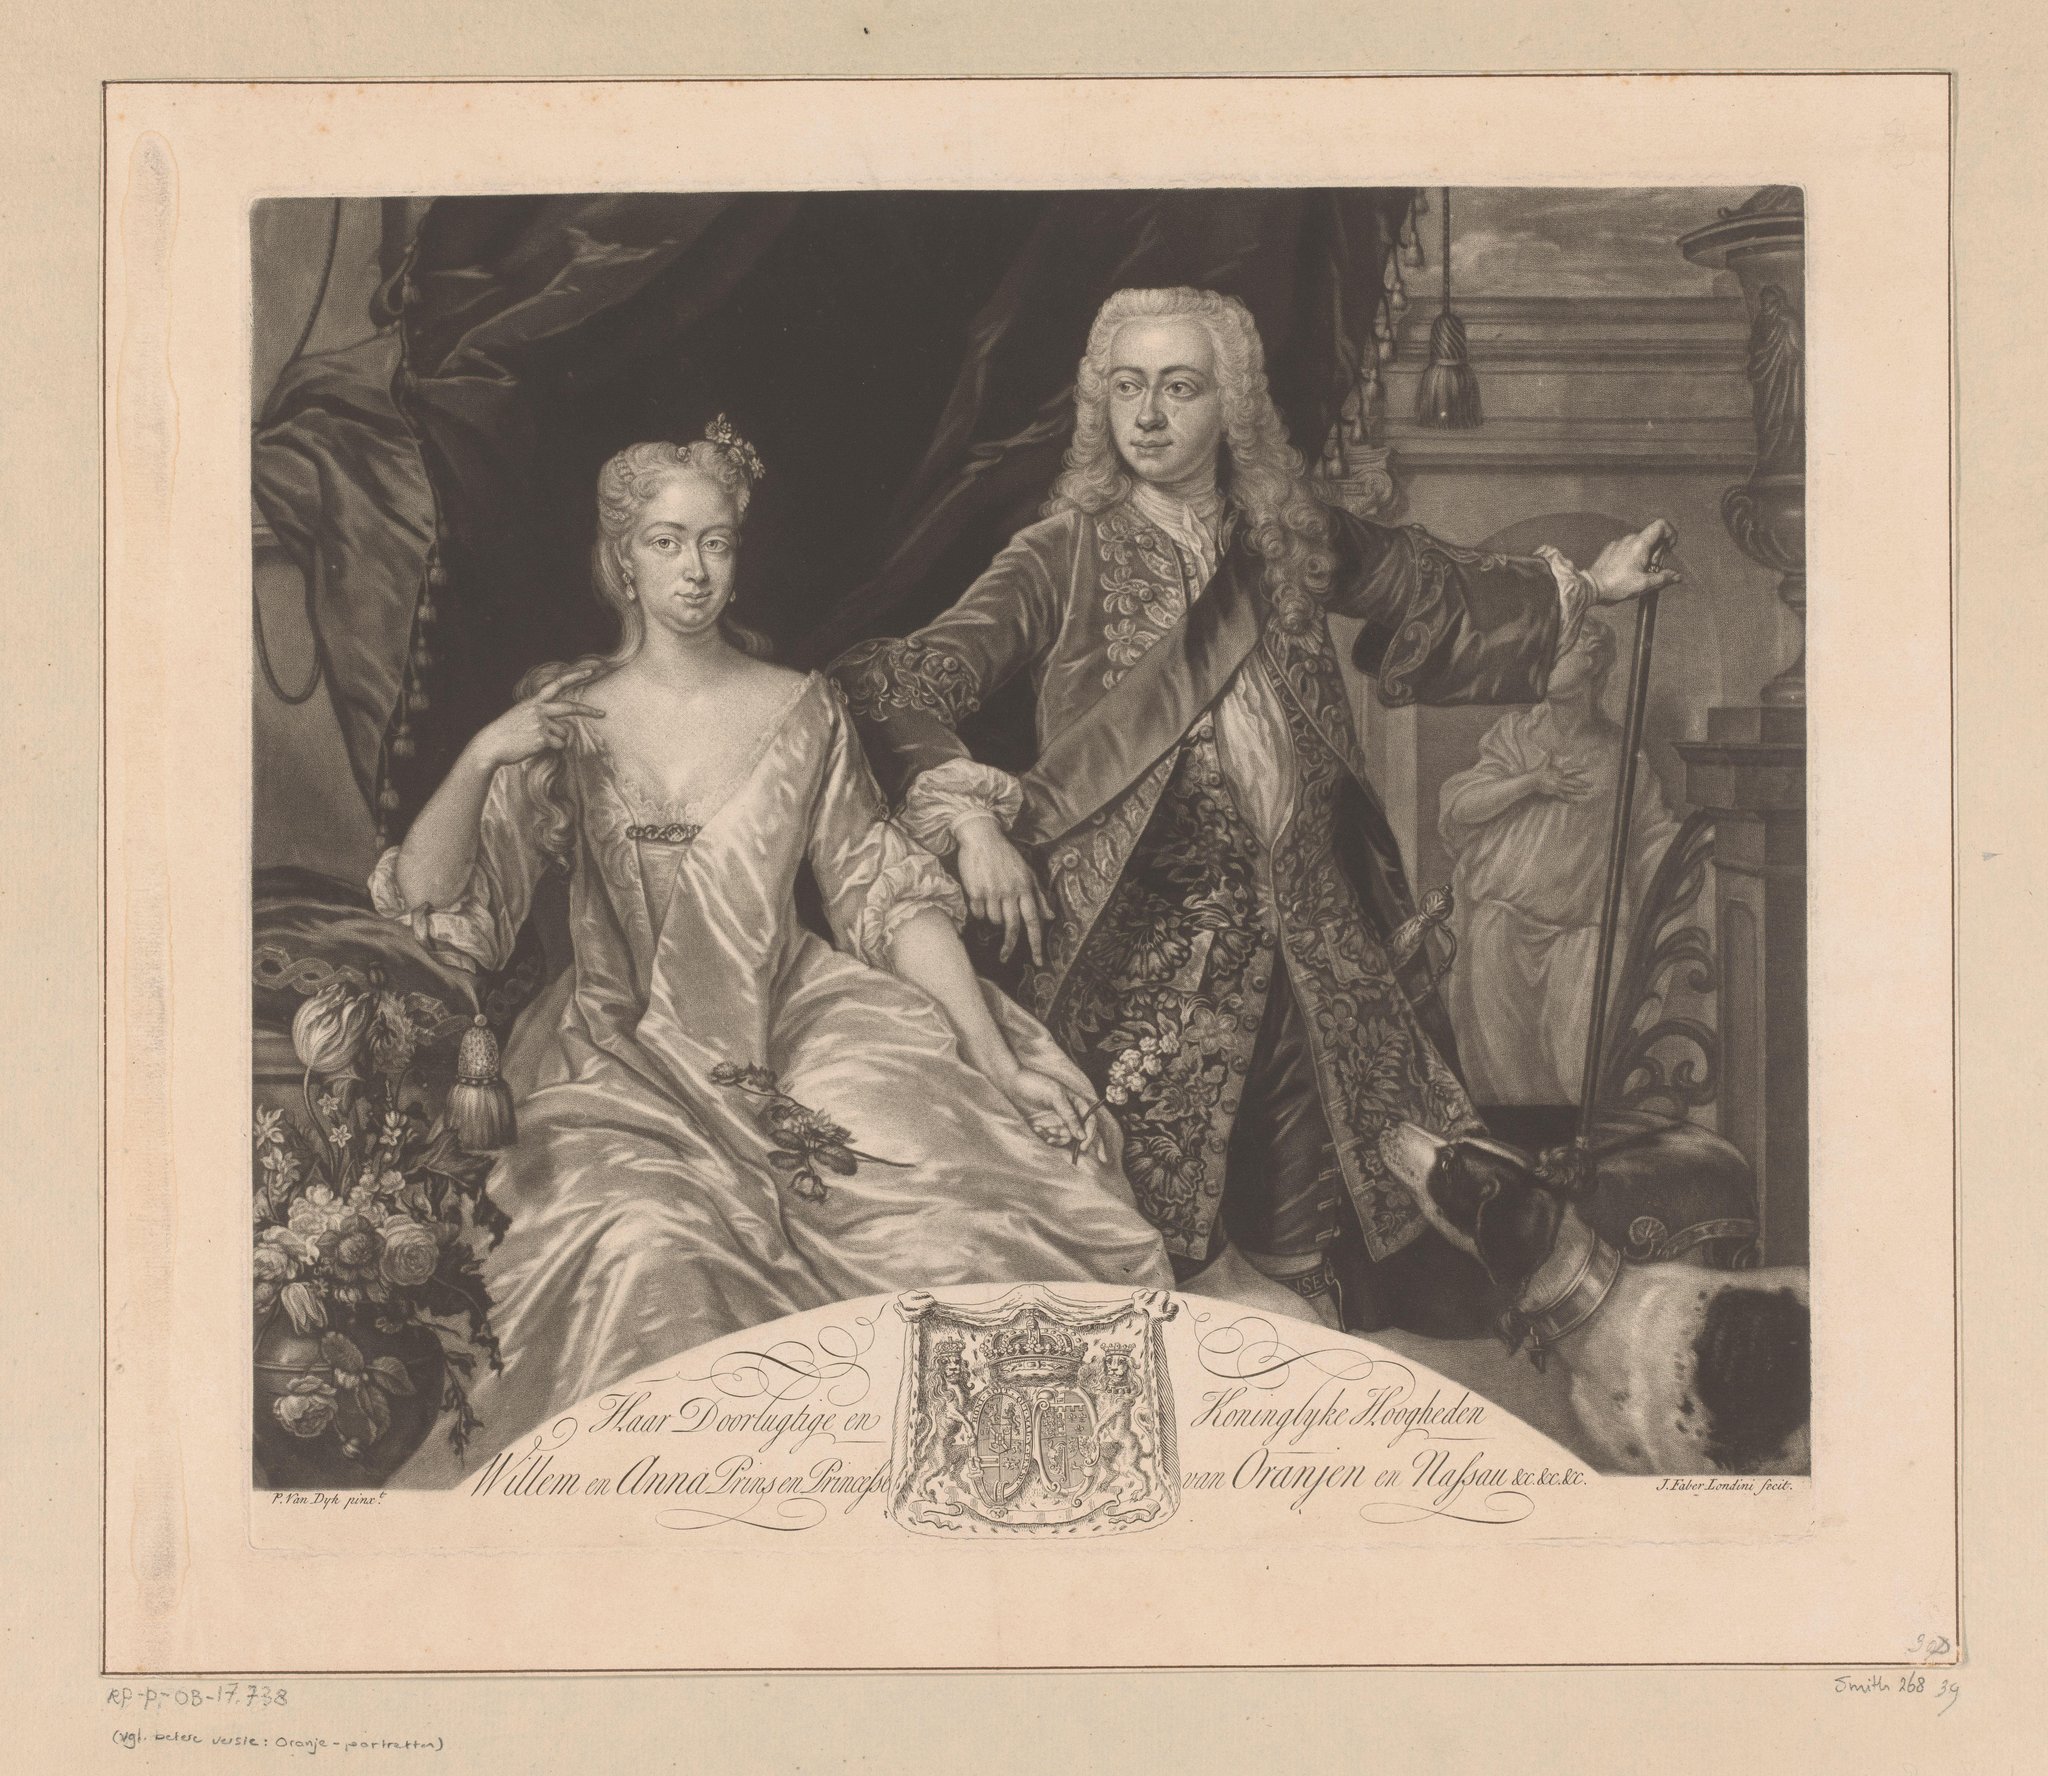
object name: print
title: Portret van Anna van Hannover en Willem IV, stadhouder en prins van Oranje-Nassau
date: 1734-1756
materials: paper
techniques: etching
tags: the hague, willem iv (prins van oranje-nassau), anna van hannover, prince, historical persons, marriage, married couple, 'matrimonium', princess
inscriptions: collector's mark: Lugt 240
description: Tekst in het Nederlands in de ondermarge.